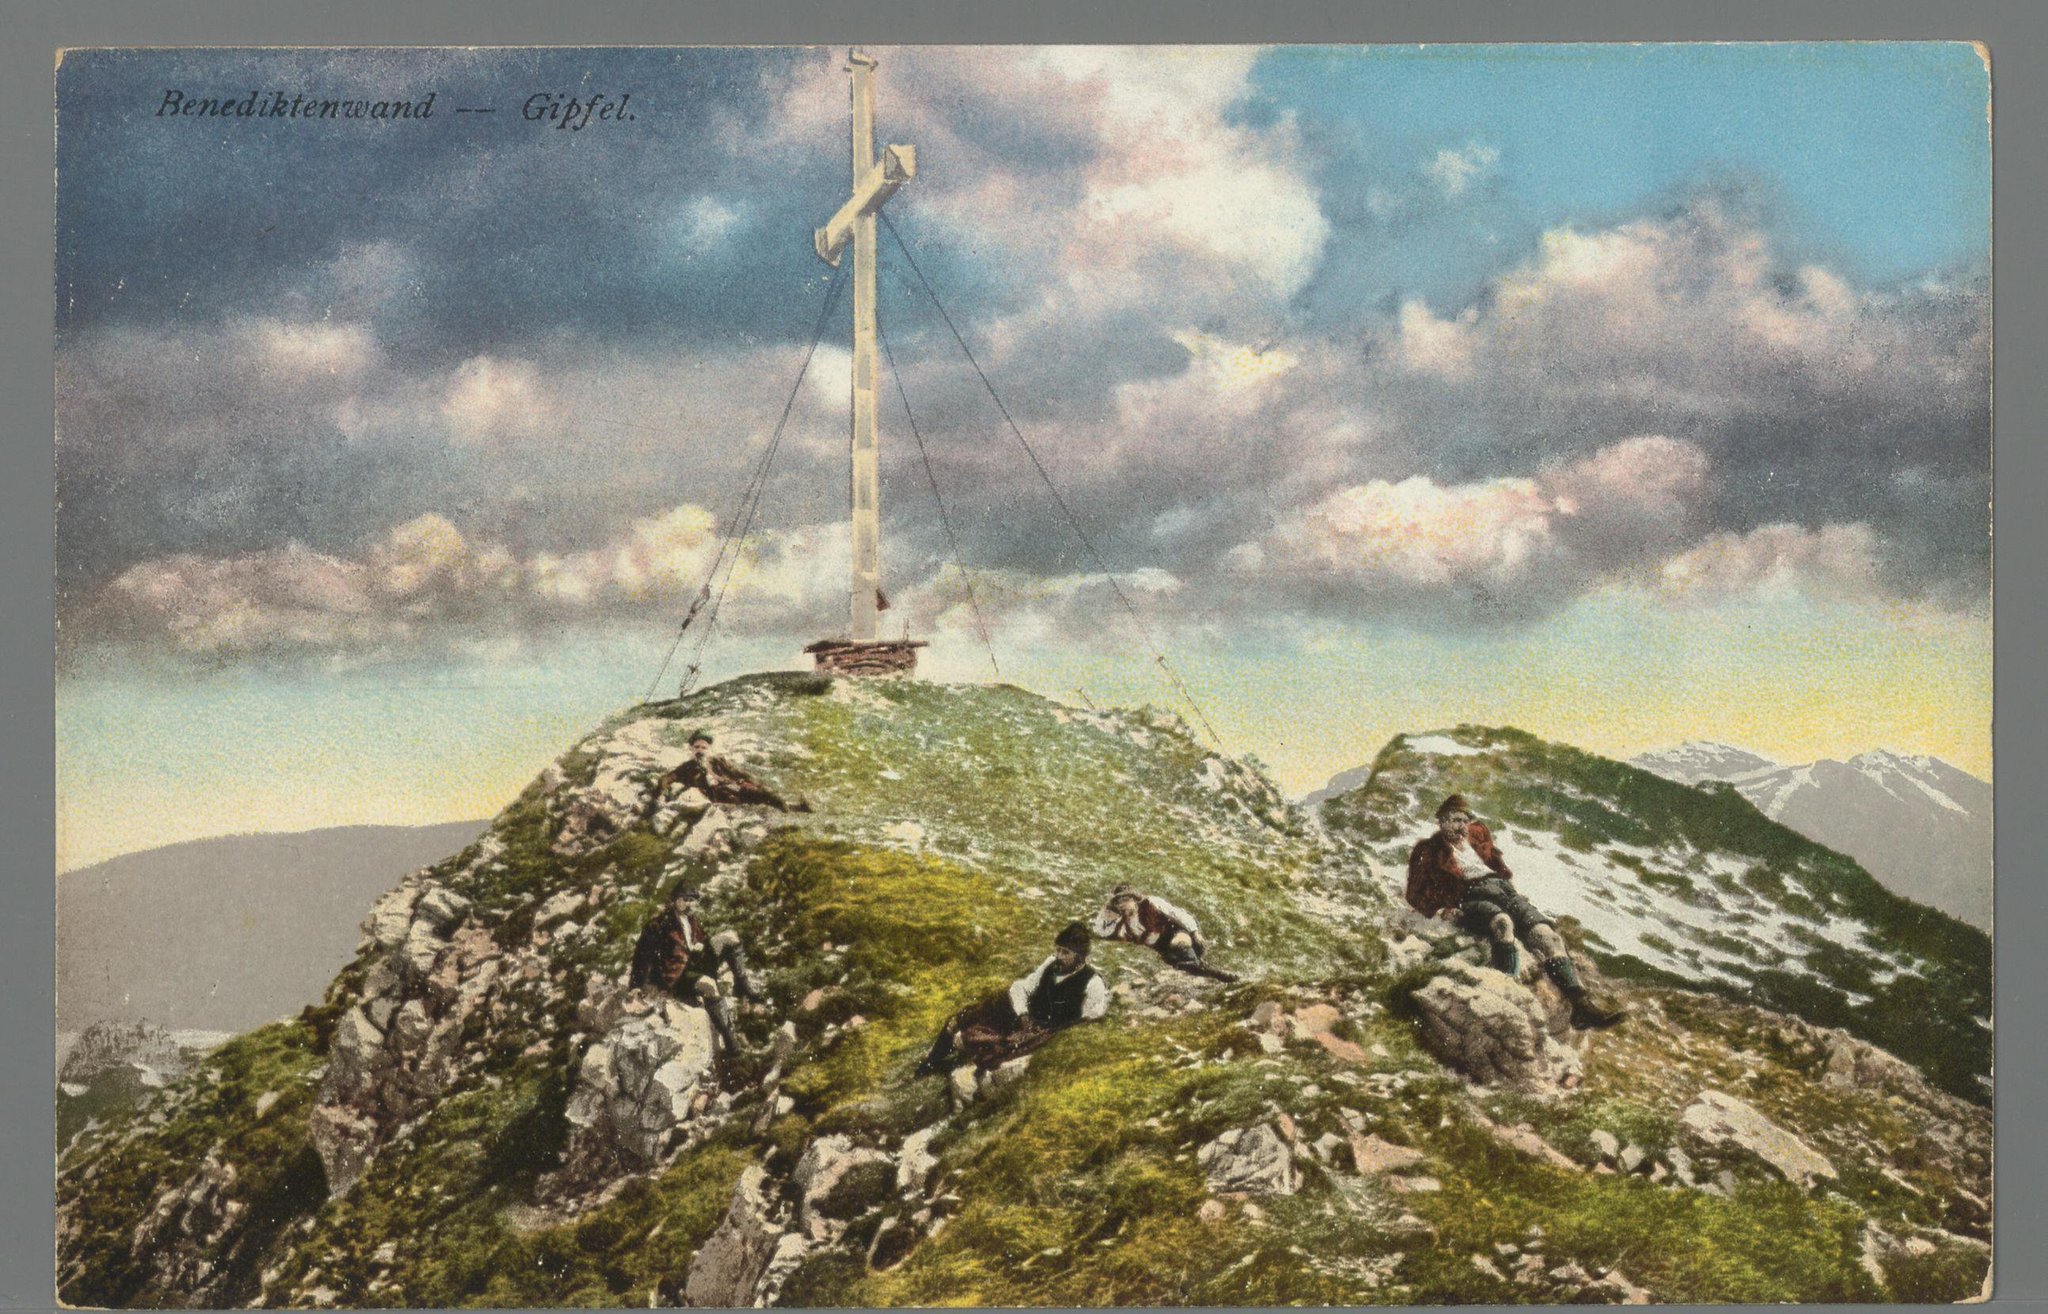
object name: print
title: Benediktenwand - Gipfel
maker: Anonymous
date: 1905-1930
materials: cardboard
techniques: lithograph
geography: benediktbeuern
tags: mountain-top, peak